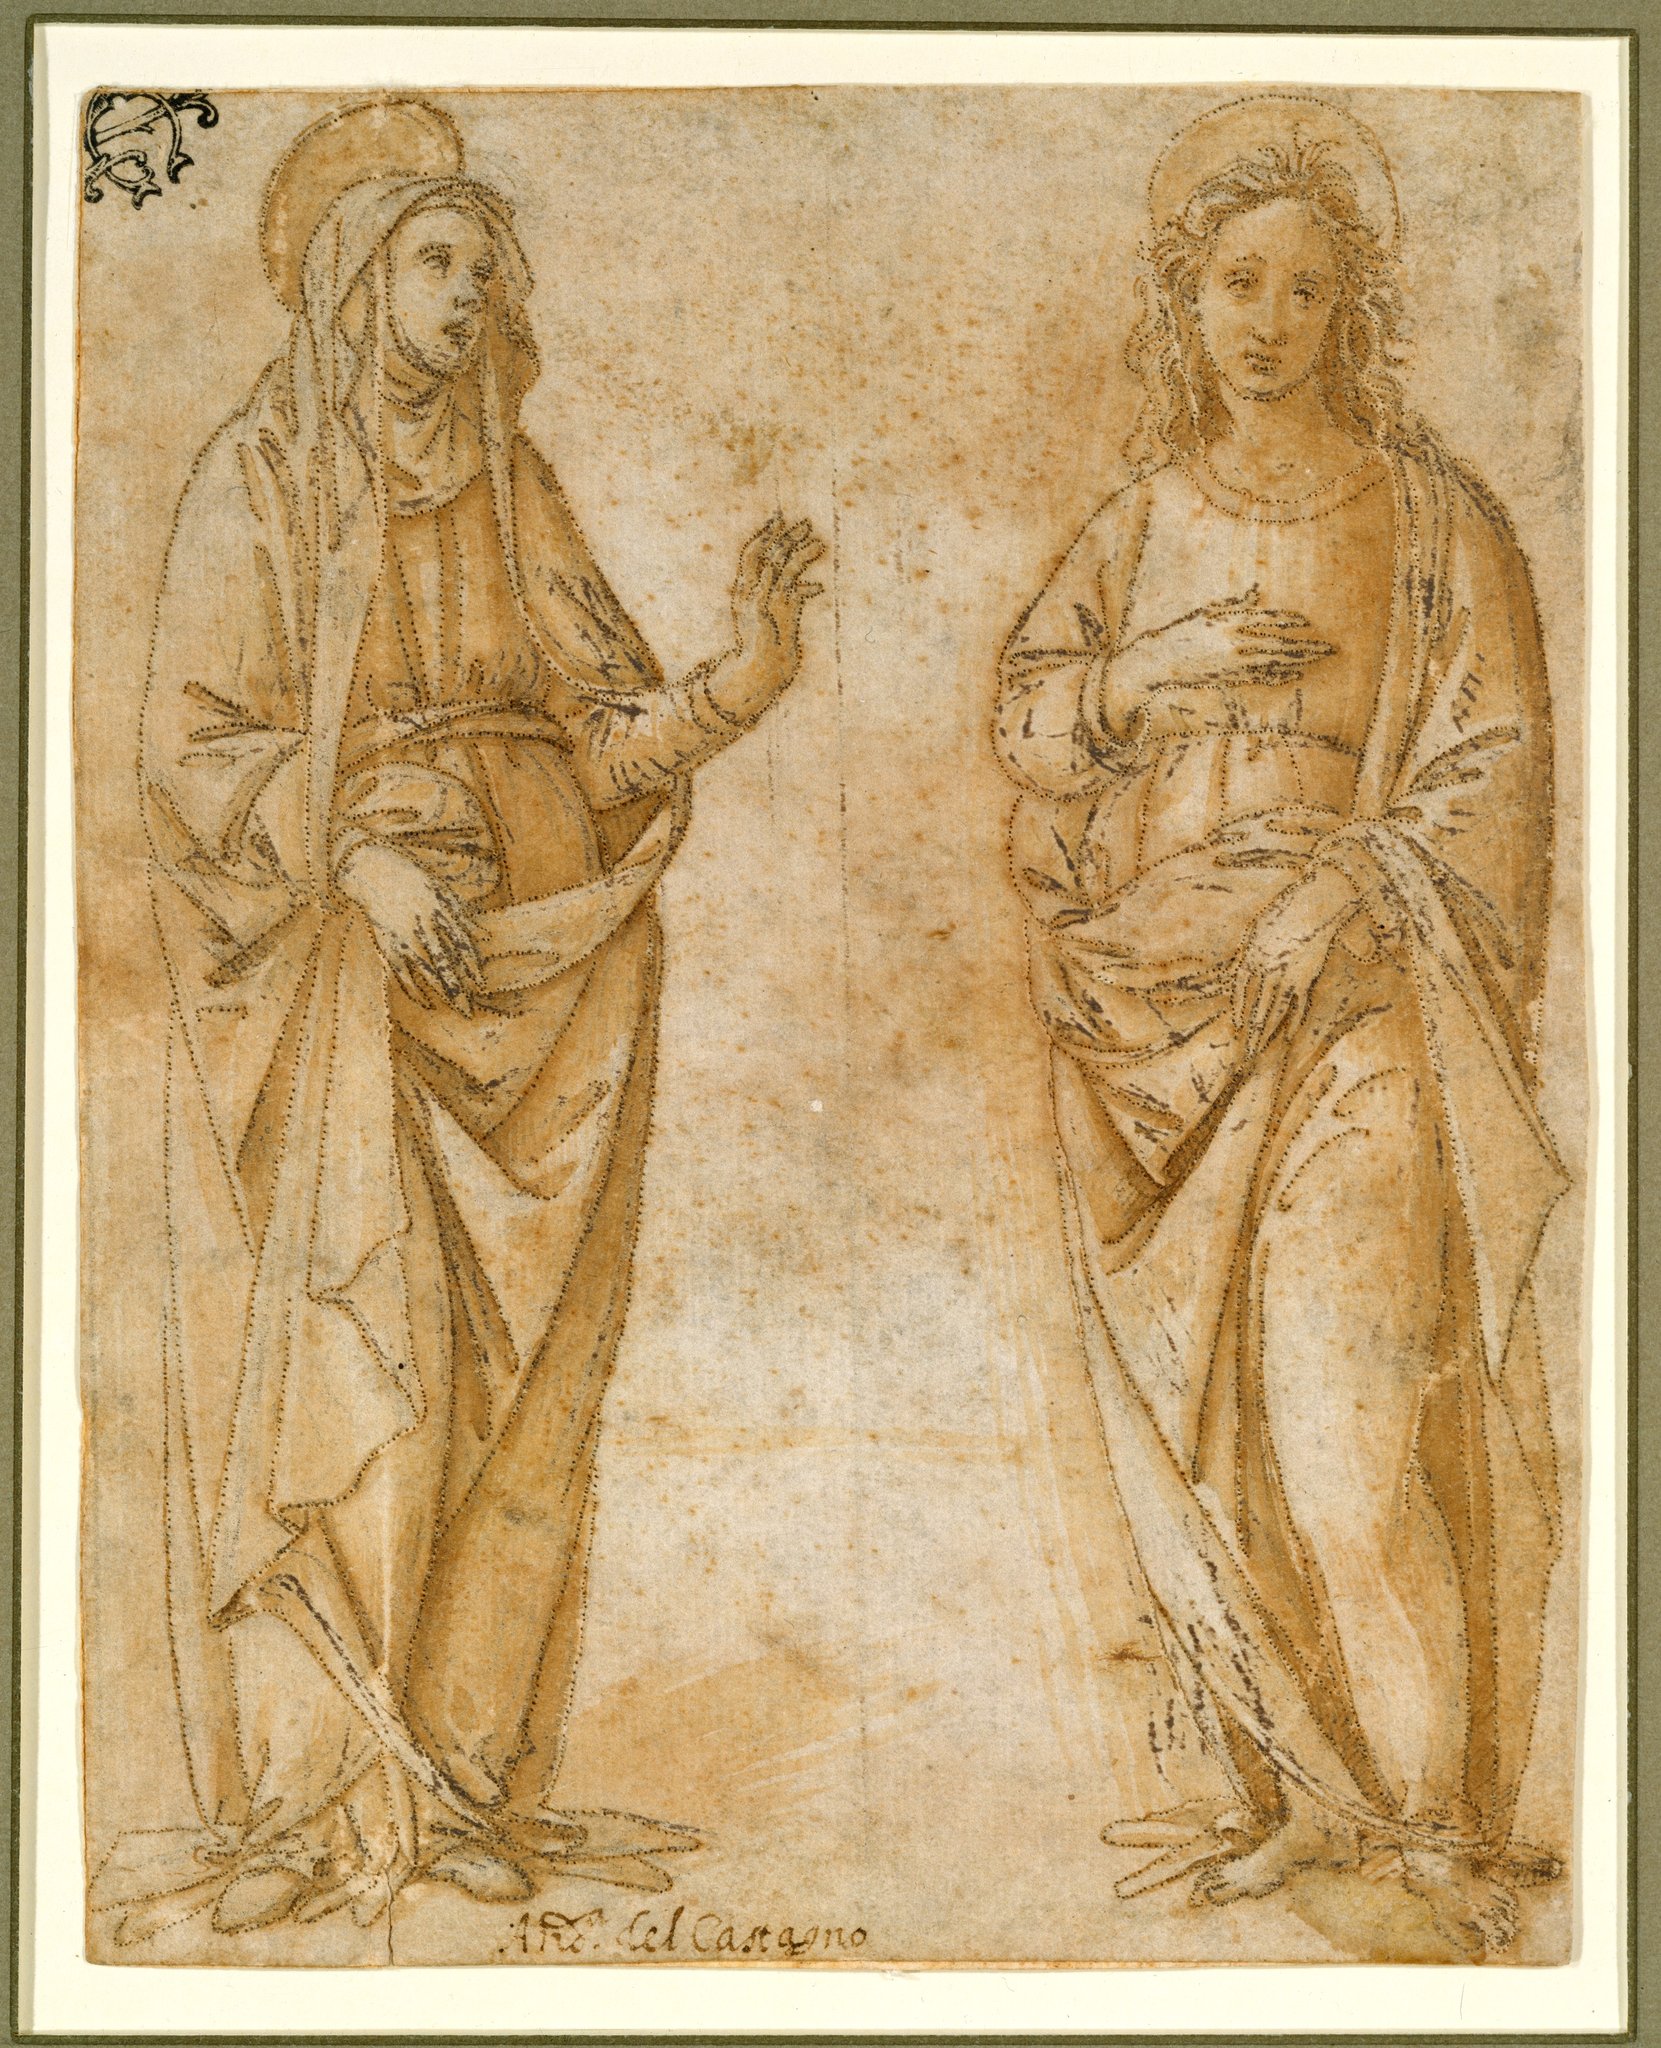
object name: drawing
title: The Virgin and Saint John the Evangelist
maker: raffaellino del garbo (also known as raffaelle de' capponi and raffaelle de' carli)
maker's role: artist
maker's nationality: italian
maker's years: 1465-1527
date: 1500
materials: chalk, ink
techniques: brush, heightening, pen, drawing, wash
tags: saint john the evangelist,virgin mary